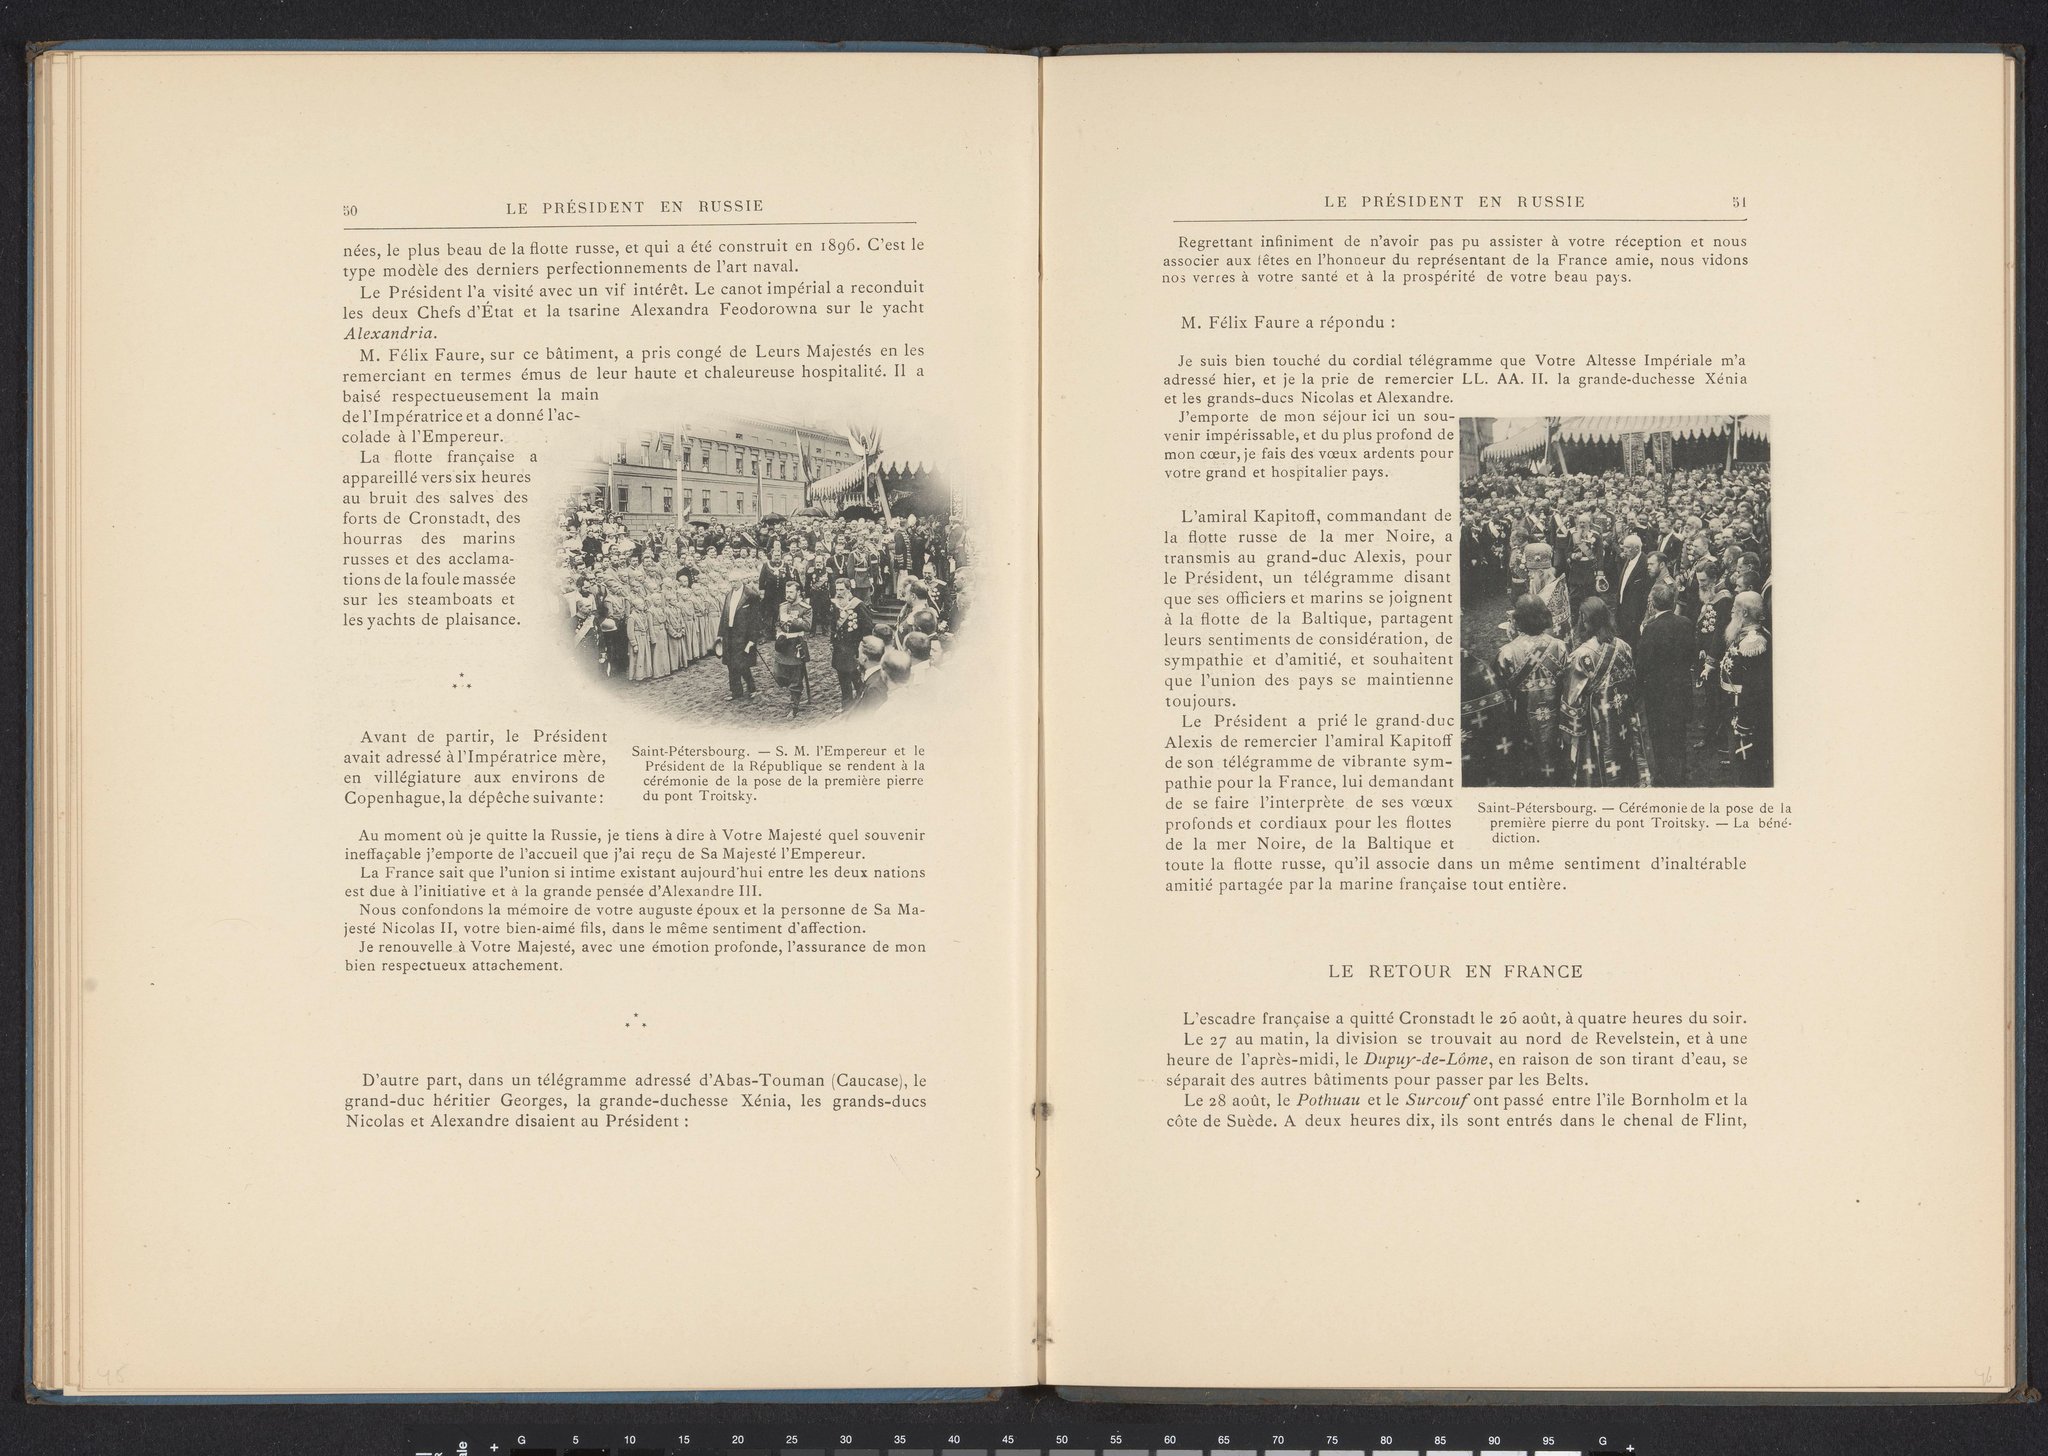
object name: page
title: President Félix Faure en tsaar Nicolaas II van Rusland bij de ceremonie van het leggen van de eerste steen van de Troitsky-brug te Sint-Petersburg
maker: Anonymous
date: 1897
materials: paper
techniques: photograph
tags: paris, ruler, sovereign, ceremonial laying of the foundations, laying the first stone, official acts of rulers, e.g. royal acts (ruler giving audience, granting mercy, etc.; ruler and his subjects), bridge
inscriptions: inscription: ‘Saint-Pétersbourg.- (...) La bénédiction.’